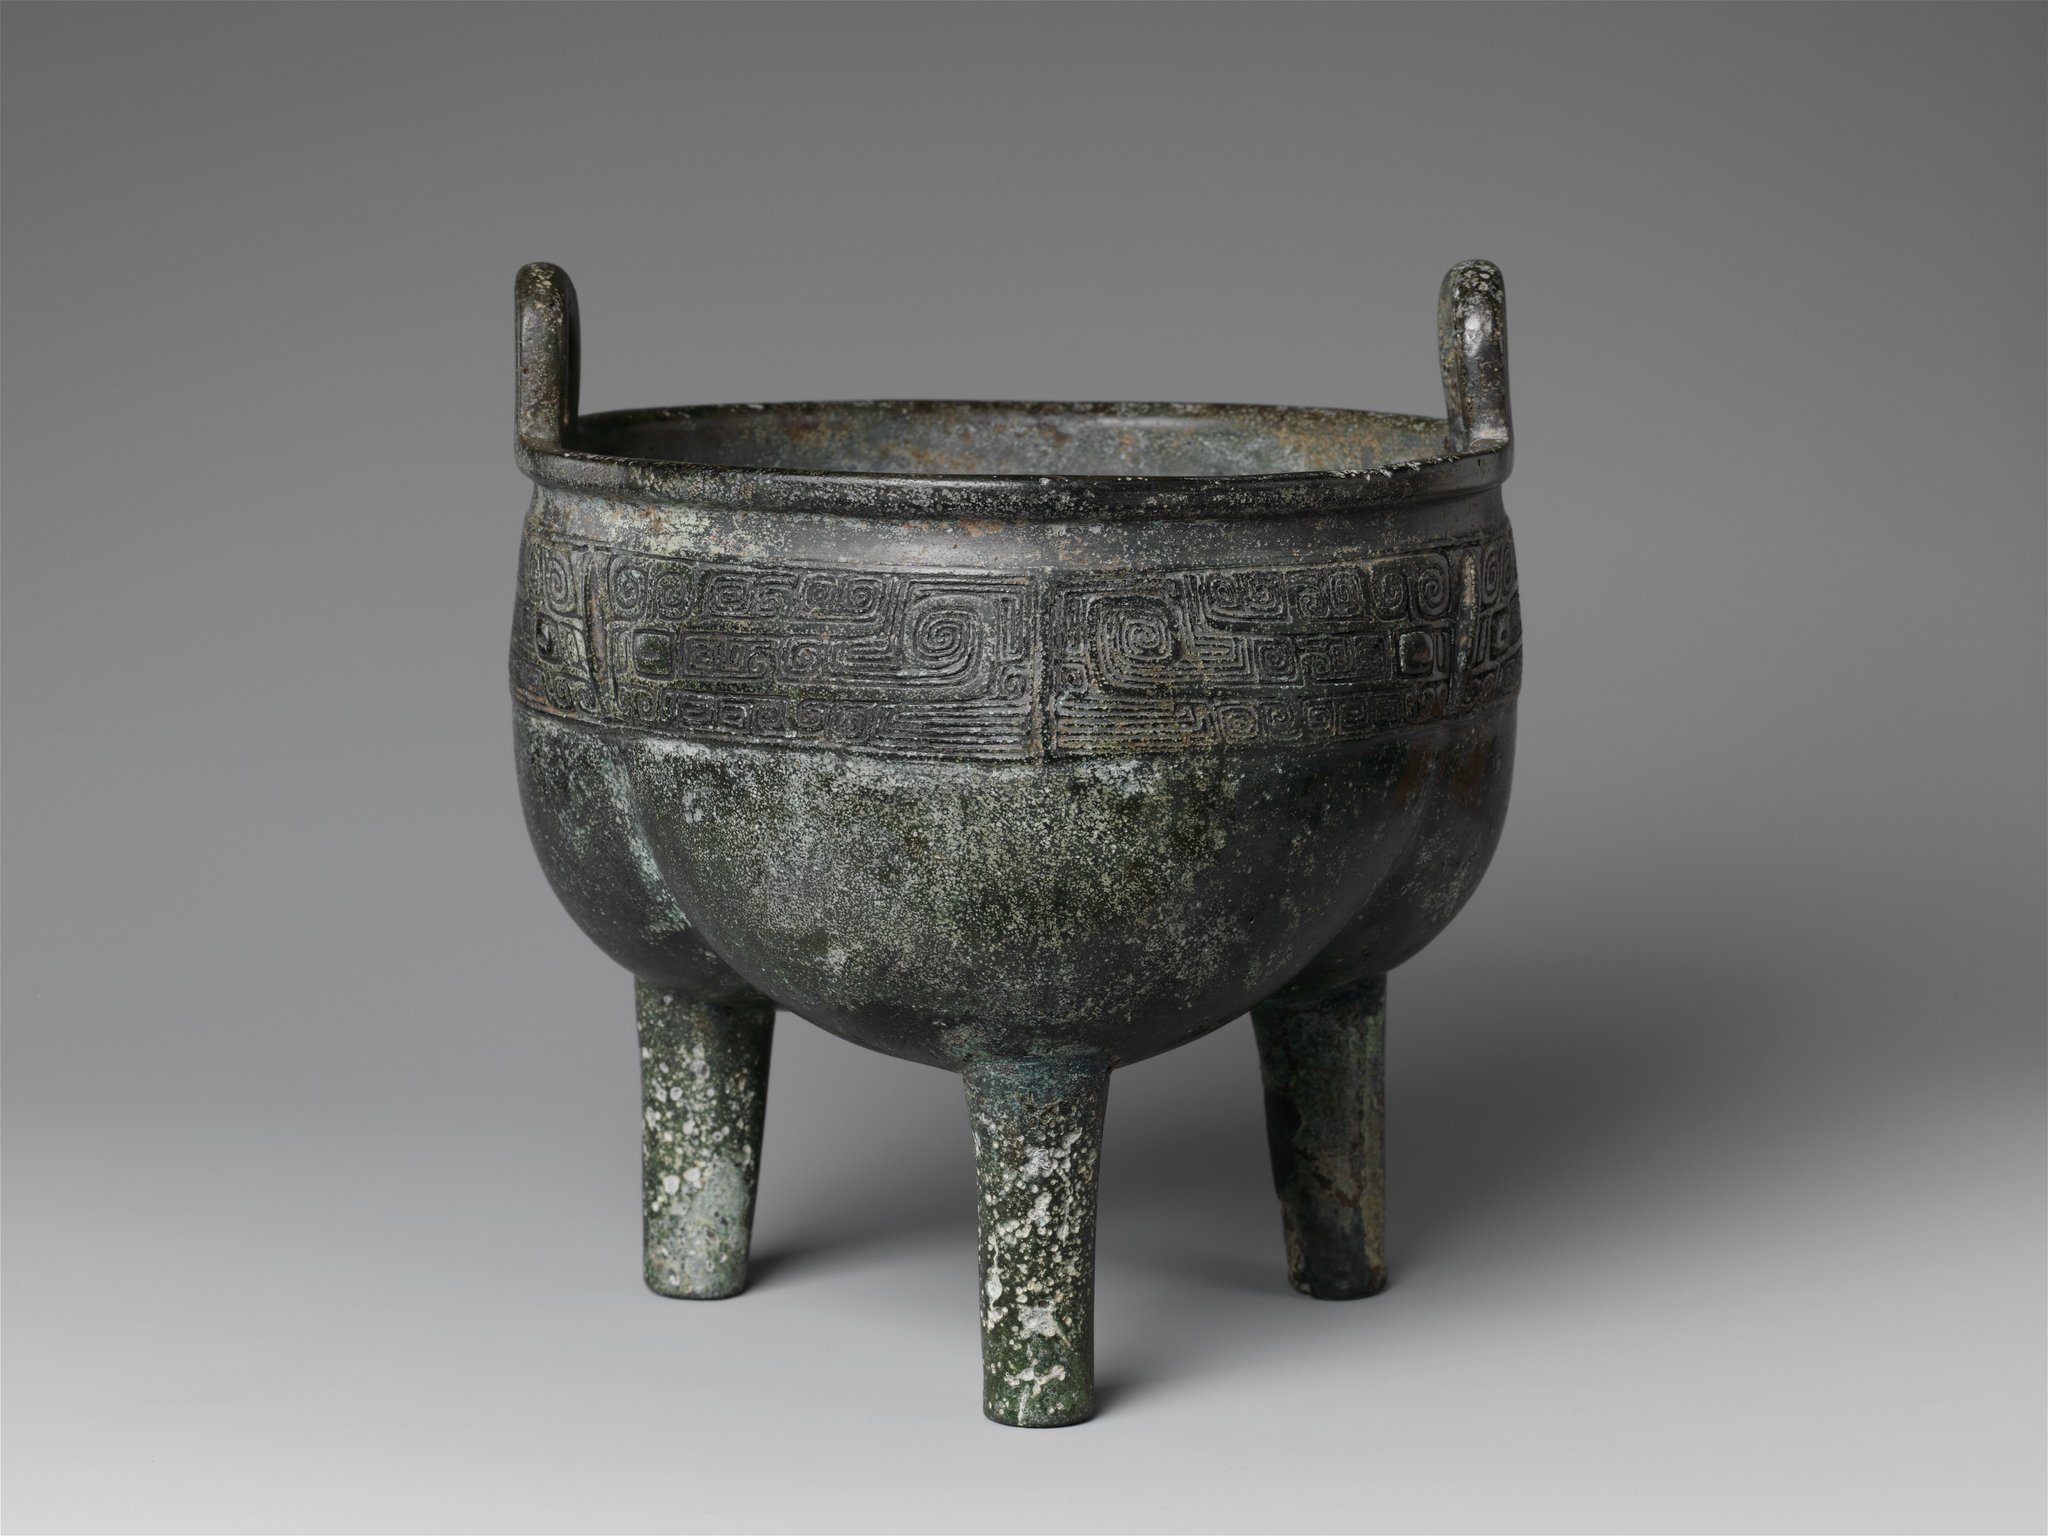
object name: vessel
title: Tripod Vessel (Liding)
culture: chinese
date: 1201-1200 BCE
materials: bronze